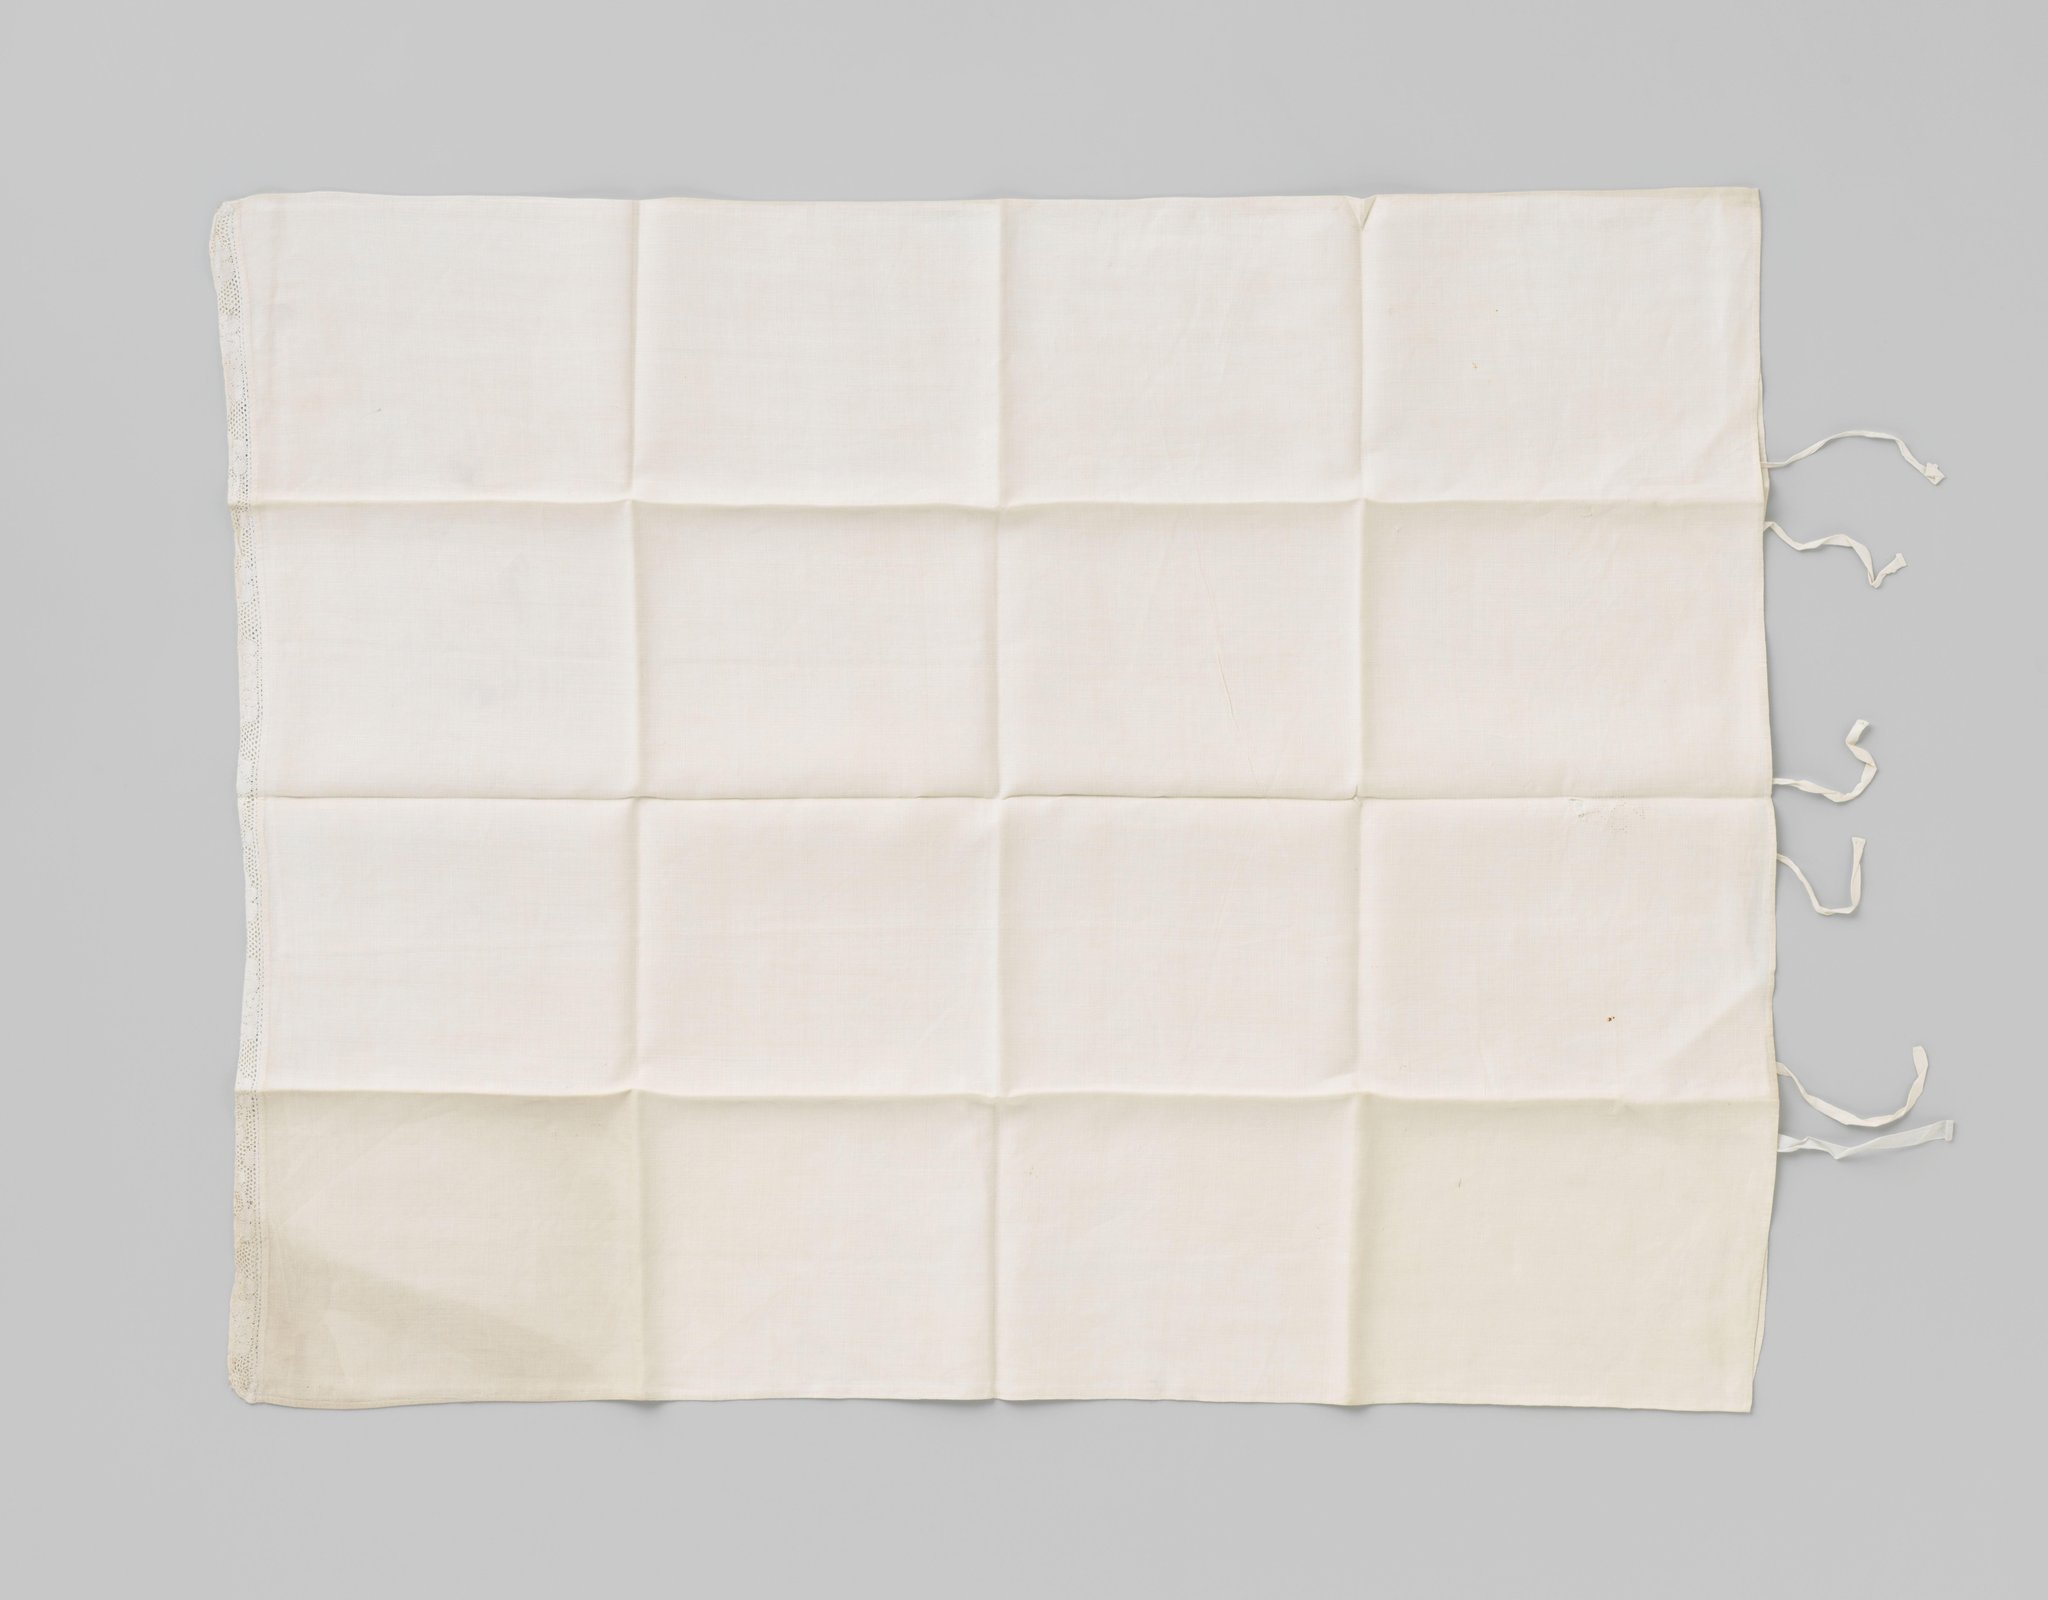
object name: pillowcase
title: Kussensloop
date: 1713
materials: linen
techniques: lace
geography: northern netherlands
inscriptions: date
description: Kussensloop van linnen met kloskant aan een uiteinde. Gemerkt kroon IIVG 4 en 1713.